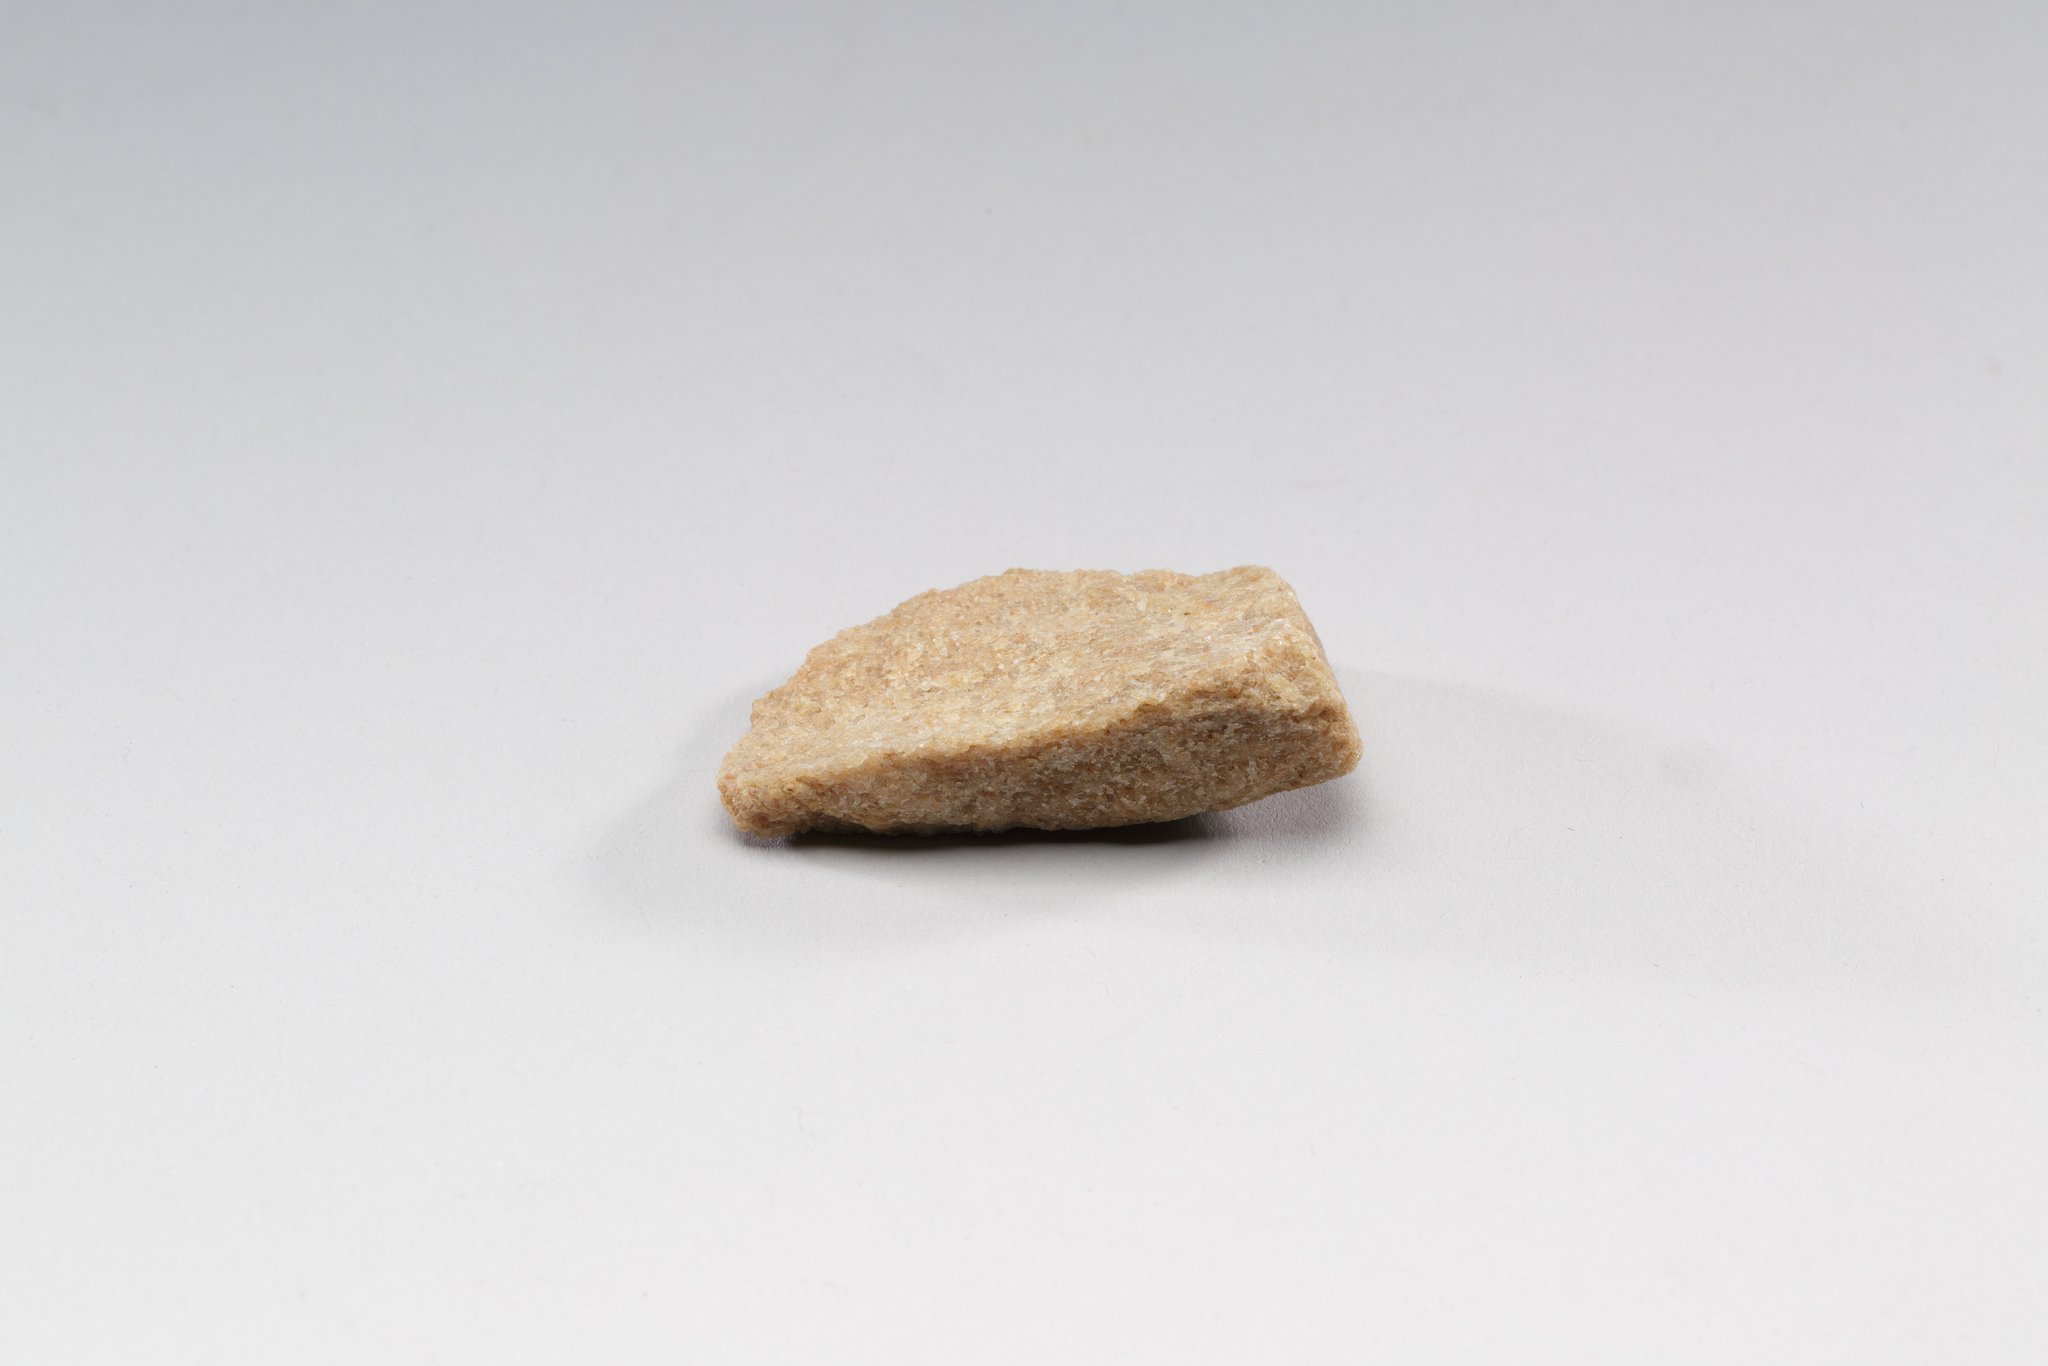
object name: rubbing stone, tool, senenmut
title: Rubbing Stone (?)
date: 1479-1458 BCE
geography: egypt